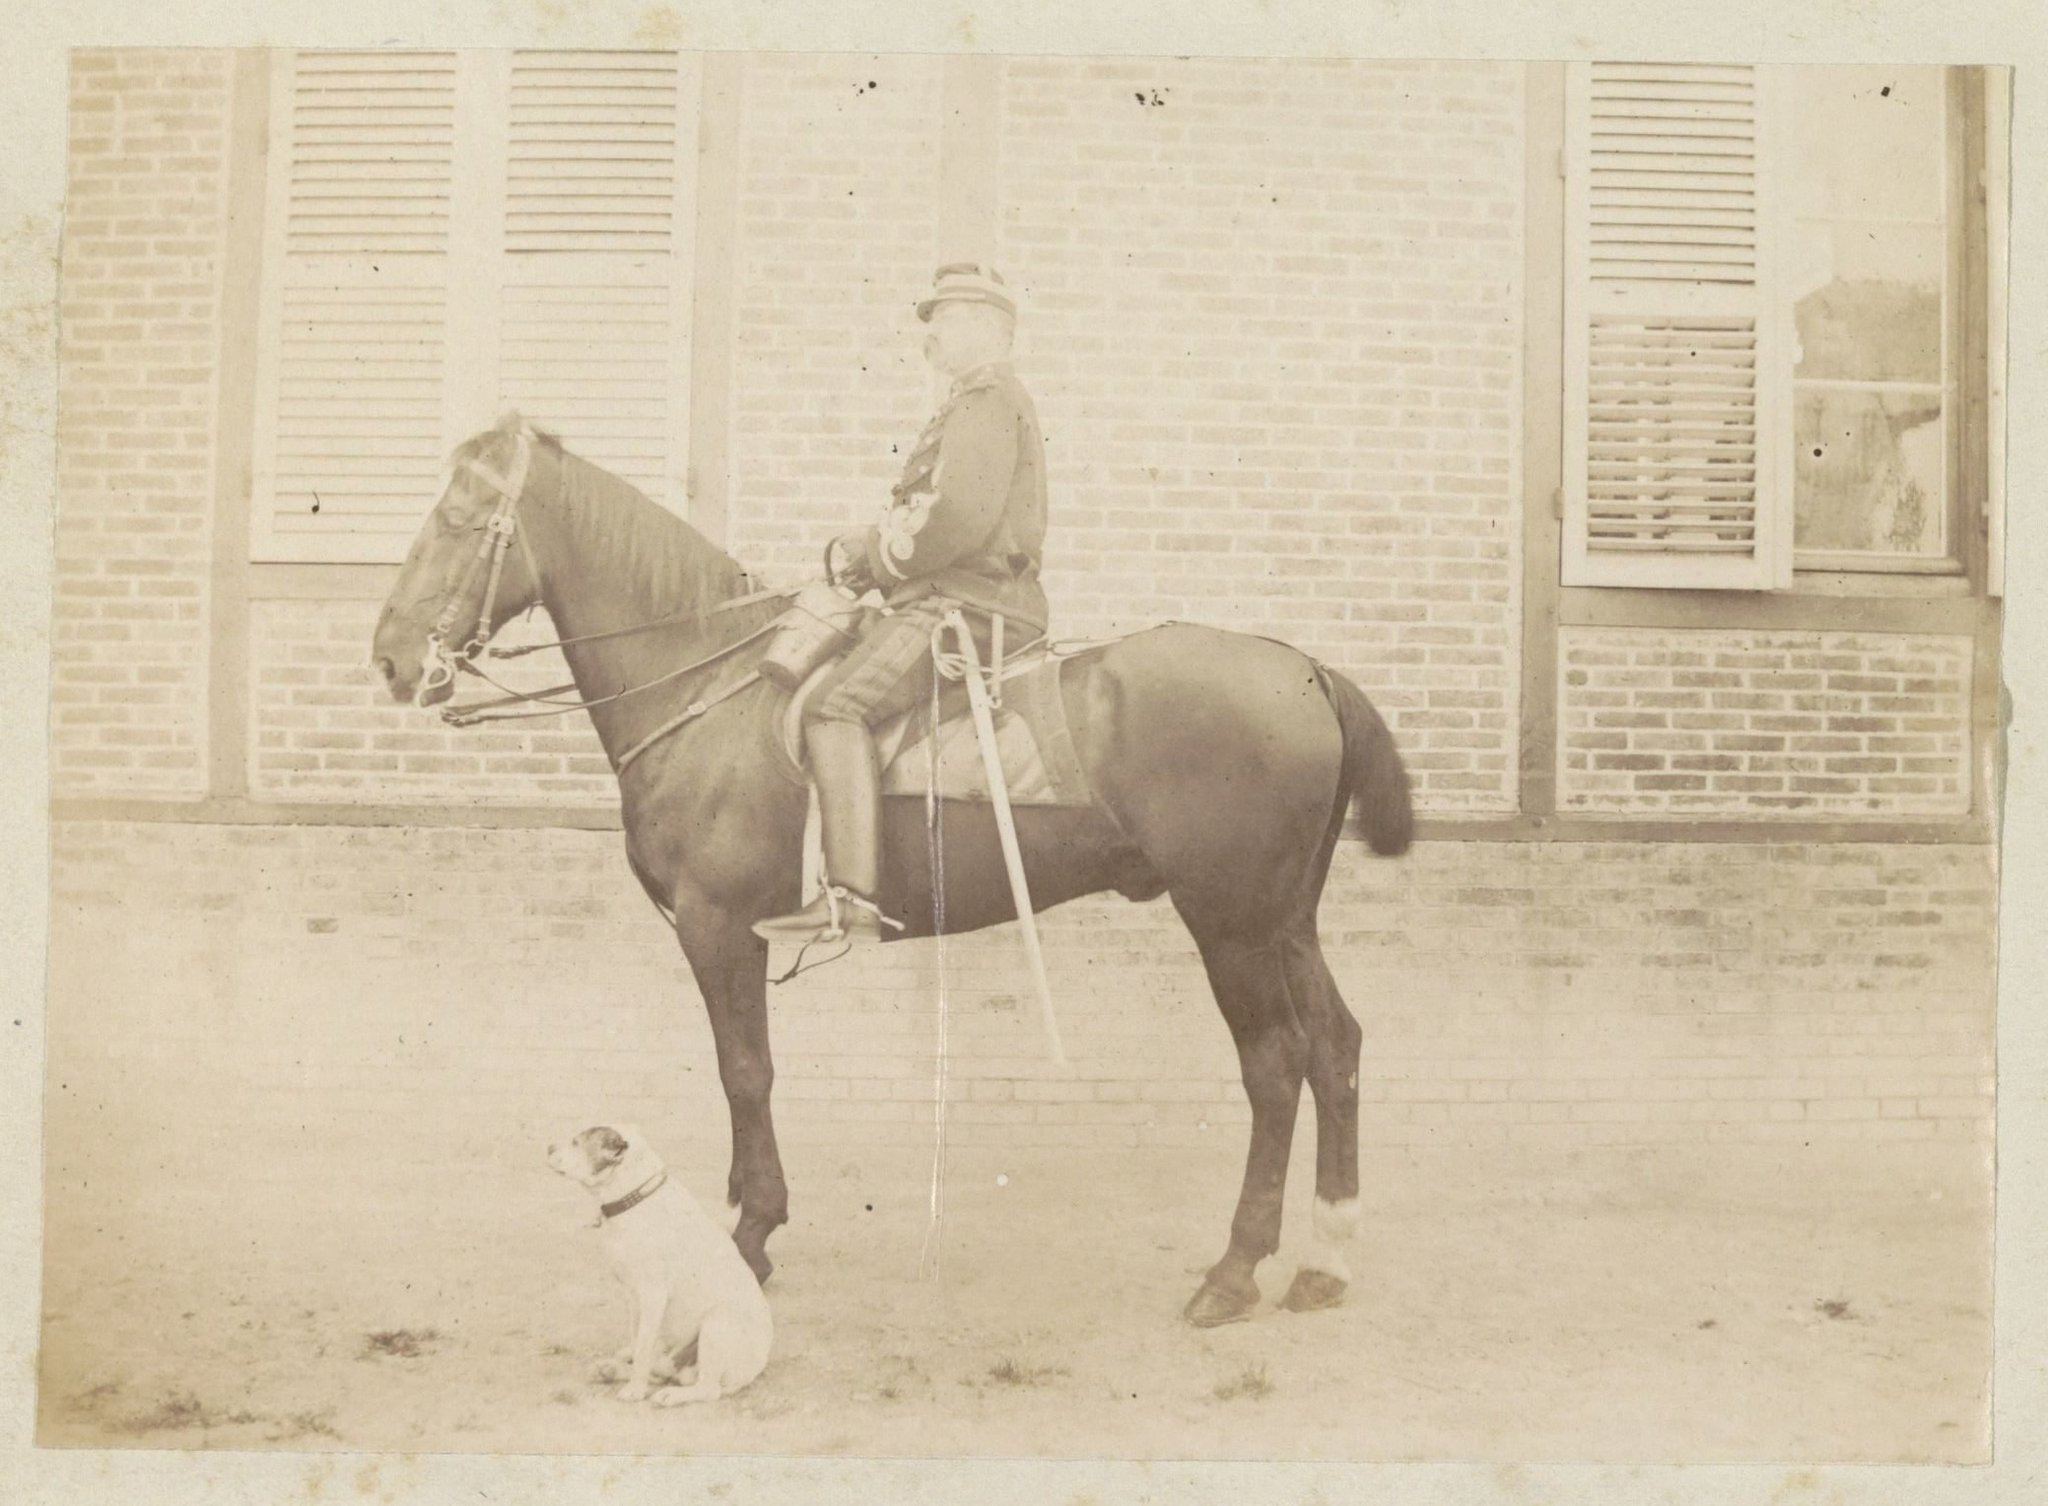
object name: photograph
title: Portret van een Franse militair te paard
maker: Anonymous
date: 1805-1884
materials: photographic support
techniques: albumen print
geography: france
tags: land forces (+ cavalry, horsemen)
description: Onderdeel van Album van een Franse amateurfotograaf met opnames van familie, militairen, industrie, landschappen en bezienswaardigheden in Frankrijk.